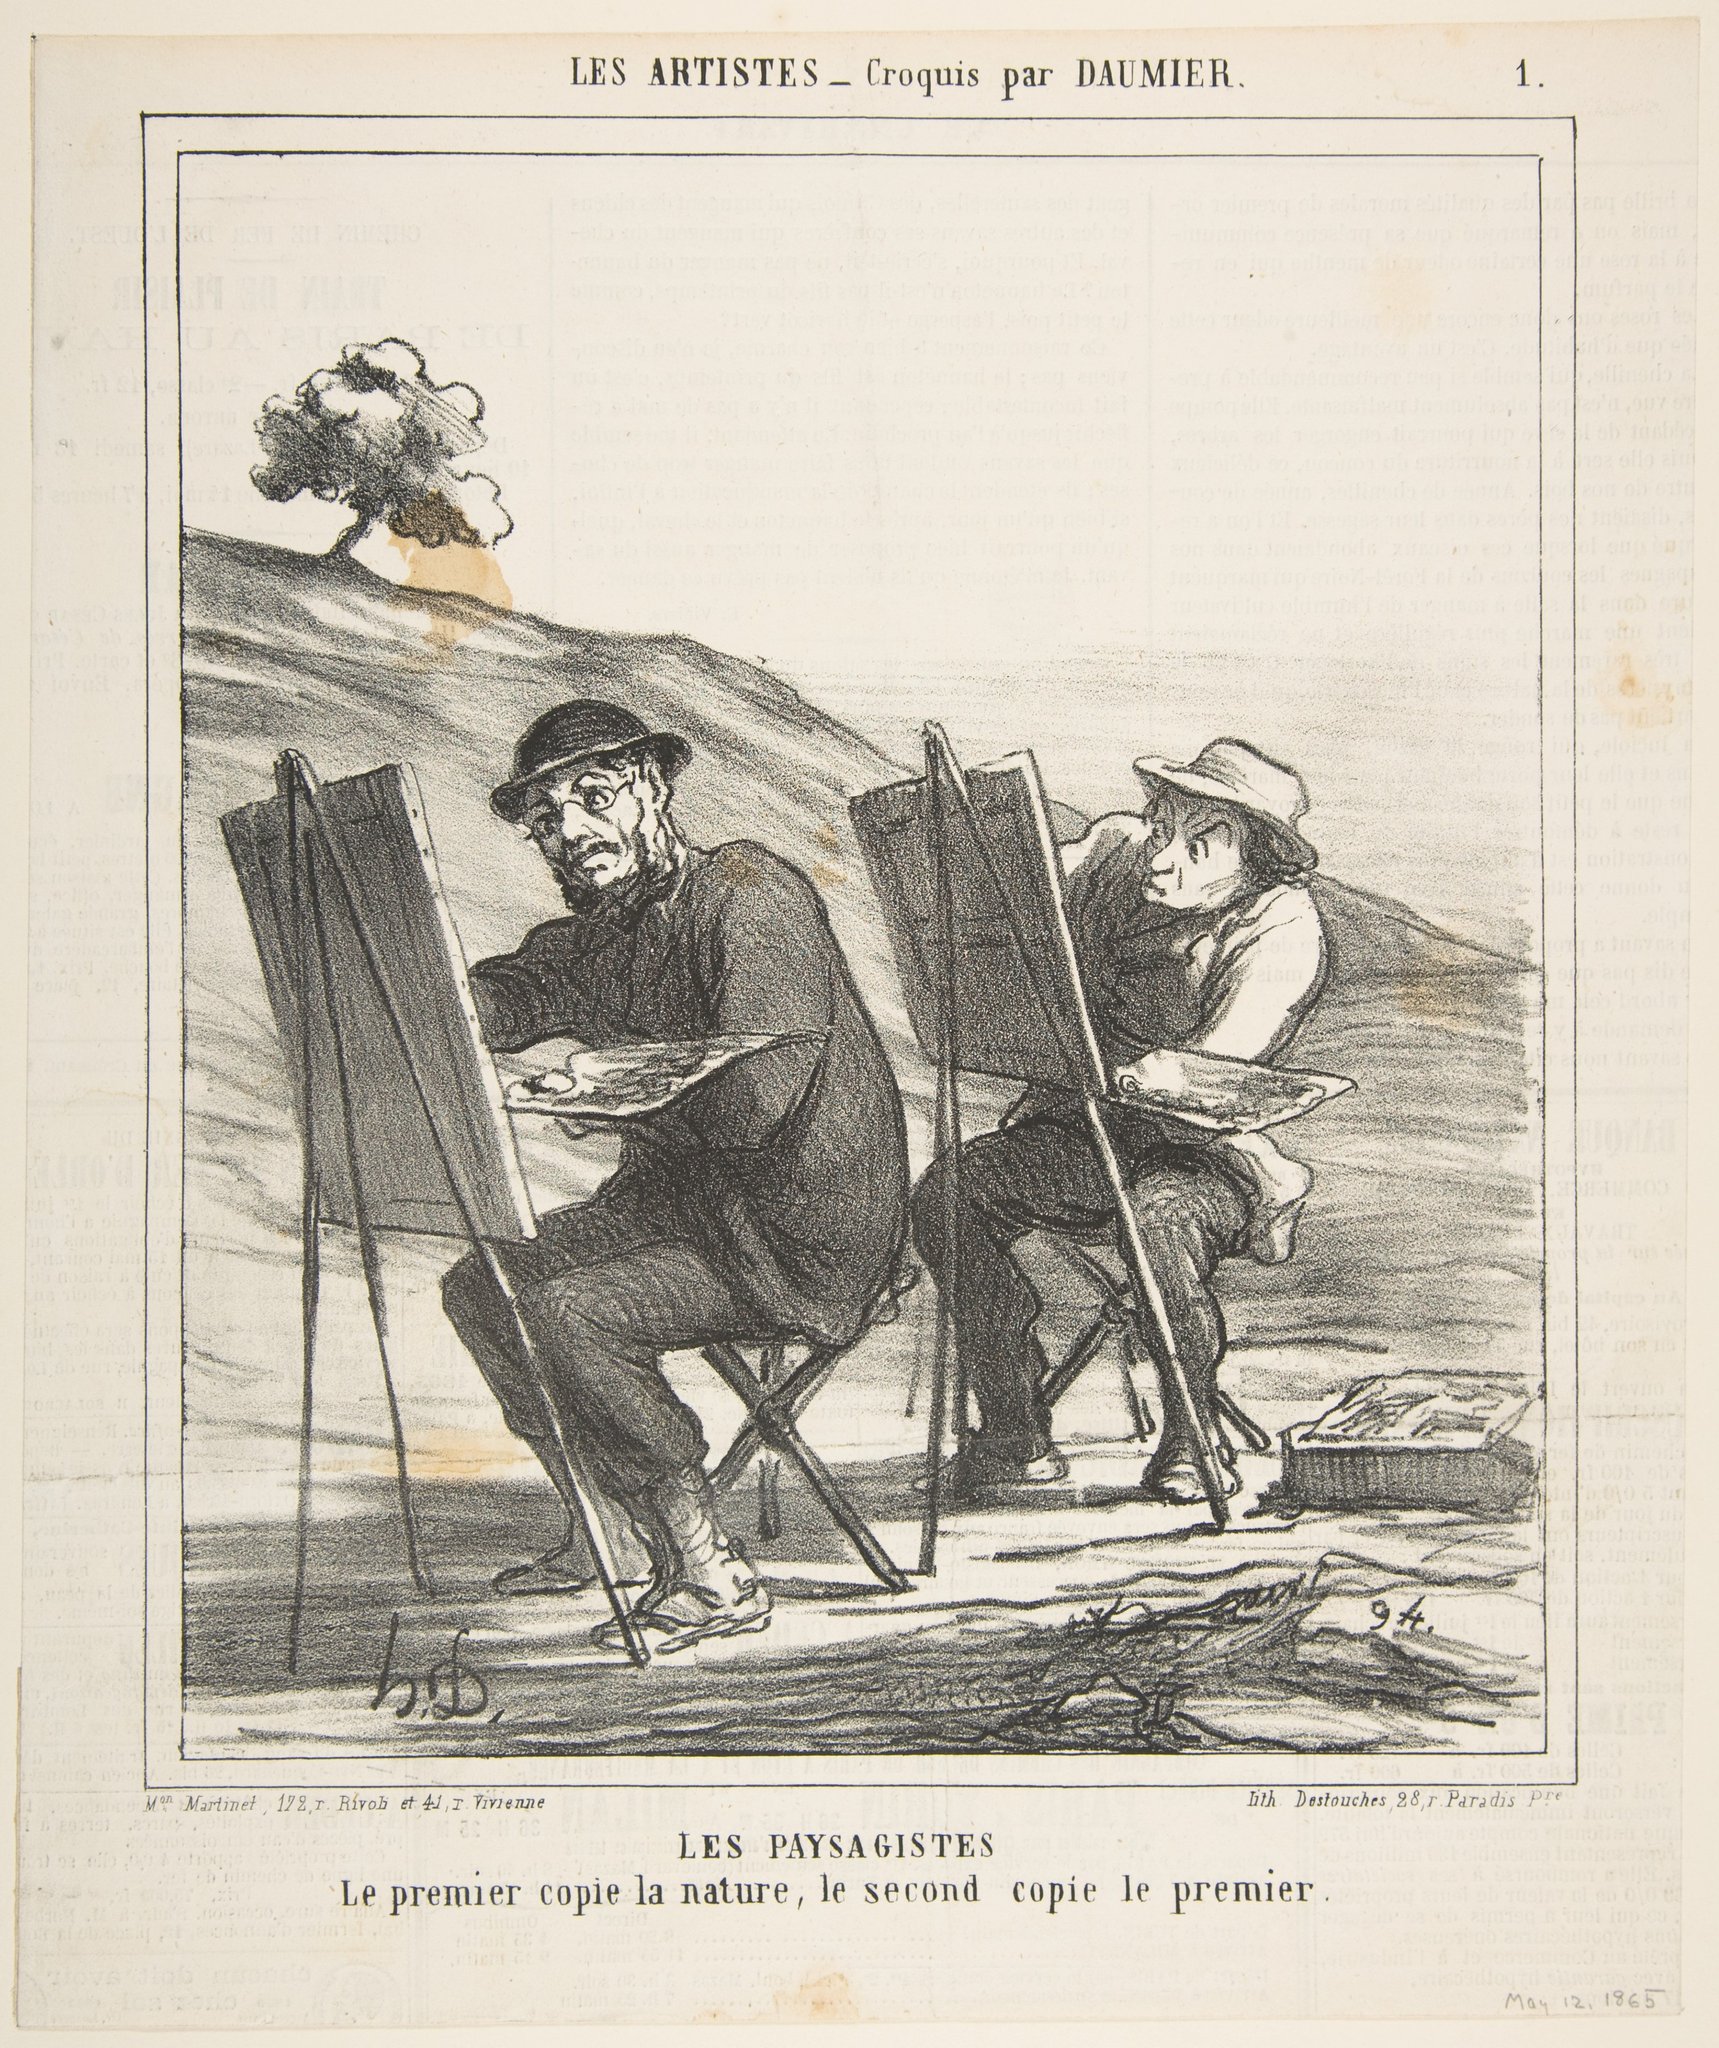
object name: print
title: The landscape painters, the first copies nature, the second copies the first, from 'The artists,' published in Le Charivari, May 12, 1865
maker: honoré daumier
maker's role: artist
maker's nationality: french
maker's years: 1808-1879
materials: paper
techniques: lithograph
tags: painting,men,trees